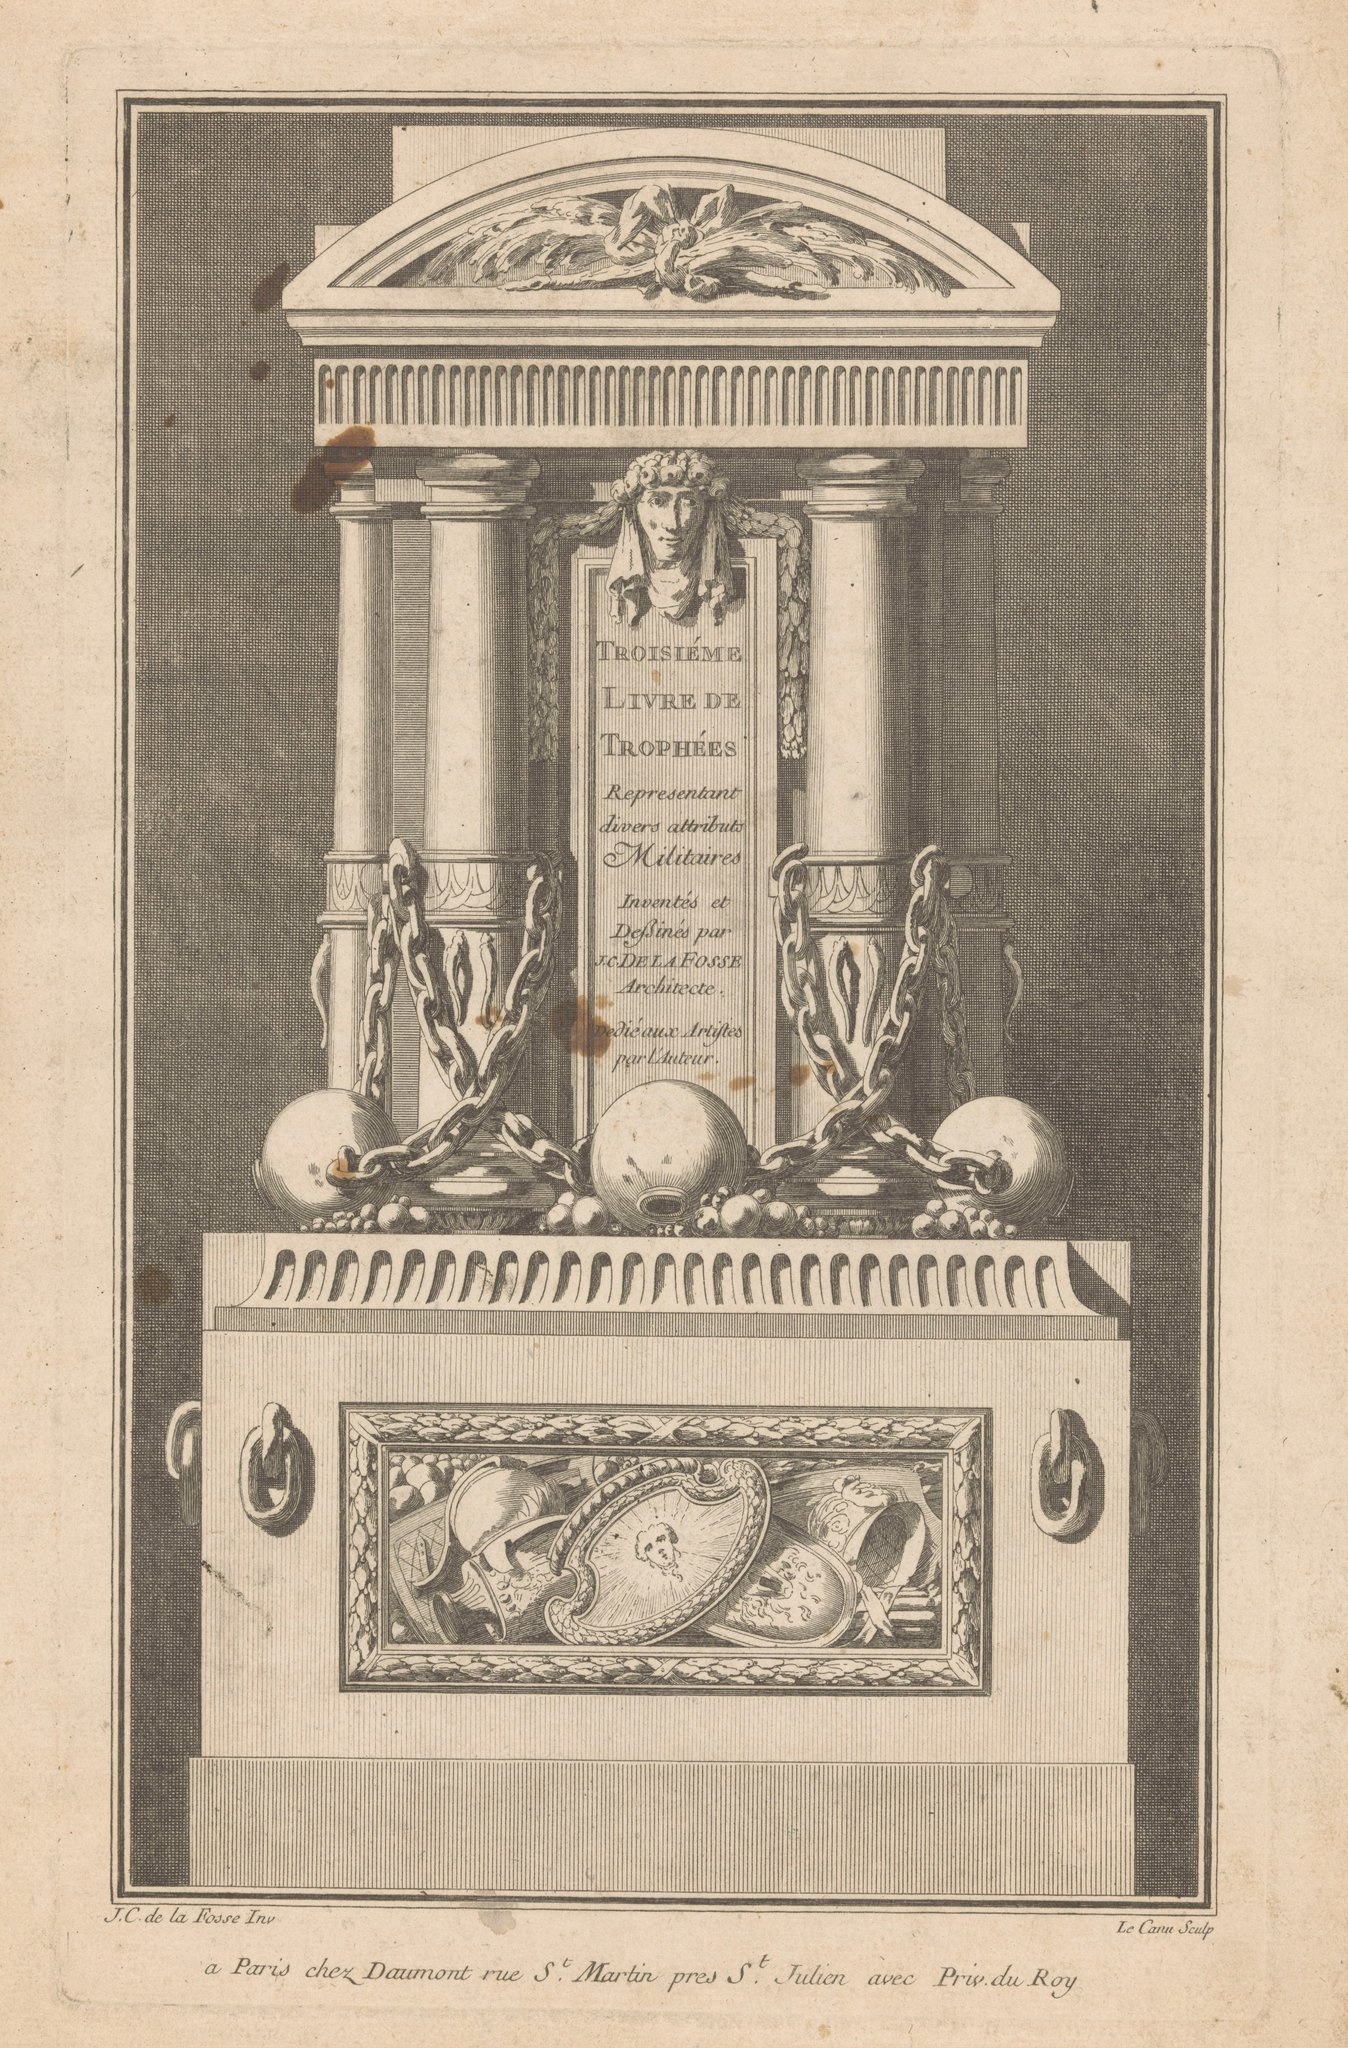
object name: titelprent, frontispice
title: Troisiéme Livre De Trophées (...)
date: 1771-1775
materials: paper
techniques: engraving, etching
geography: paris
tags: ammunition, altar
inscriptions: collector's mark: Lugt 2760, collector's mark: Lugt 2228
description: Een altaar met kettingkogels verbonden aan zuilen, in het midden de serietitel.